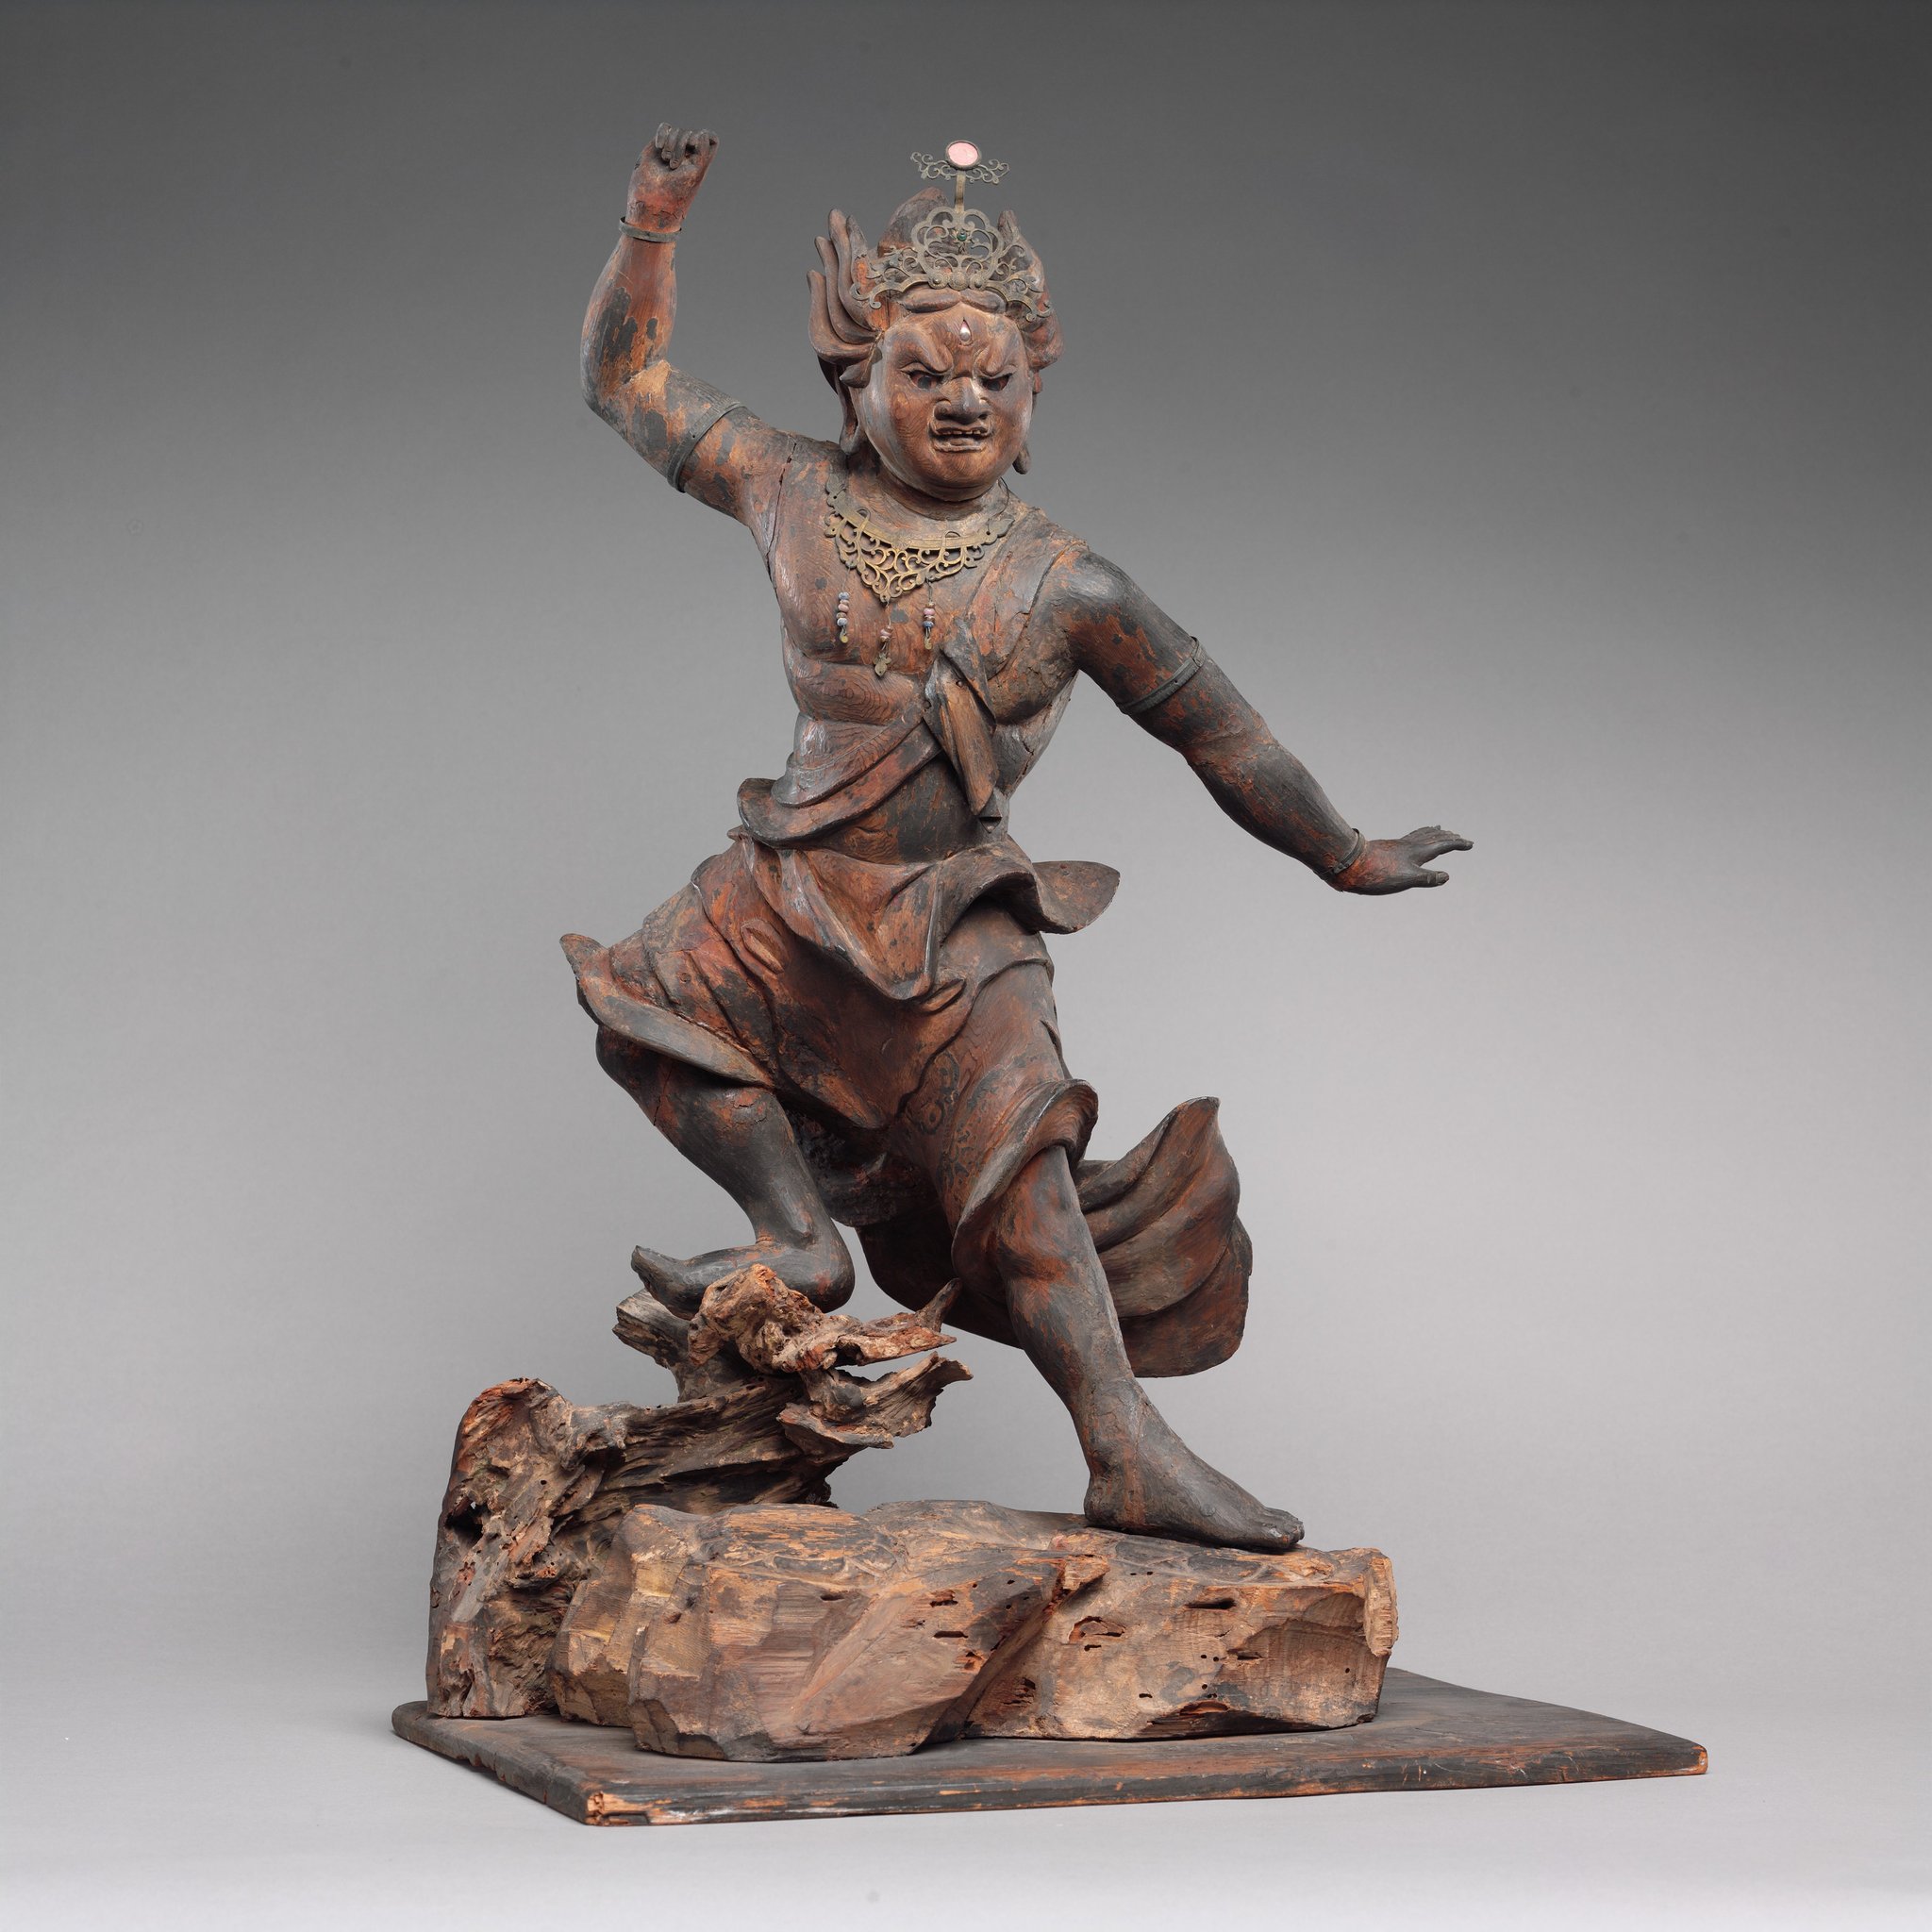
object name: figure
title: Zaō Gongen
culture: japanese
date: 1301-1400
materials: crystal, gilt bronze, wood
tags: buddhism,deities